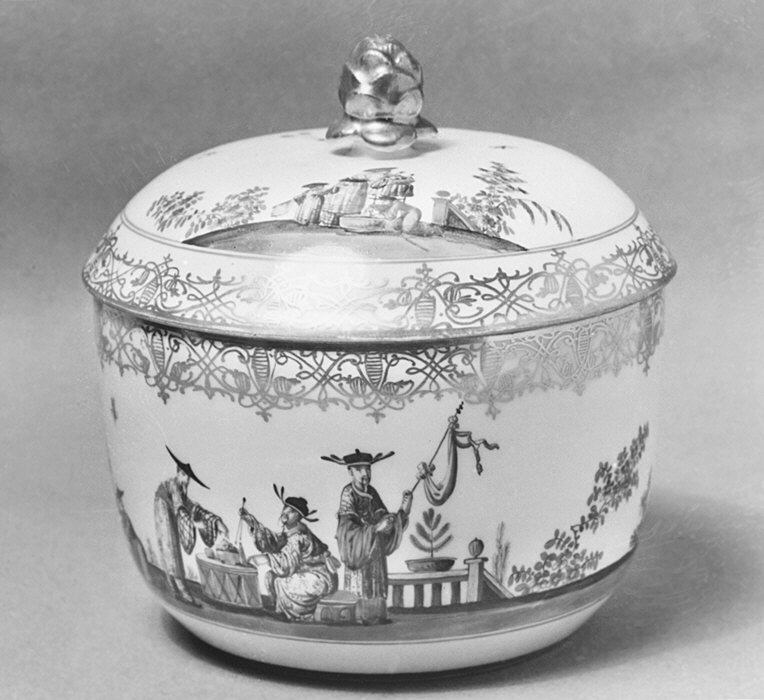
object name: sugar bowl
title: Sugar bowl (part of a set)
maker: meissen manufactory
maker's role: manufactory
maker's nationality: german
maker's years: 1710-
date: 1735-1740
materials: hard paste porcelain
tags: chinoiserie,men